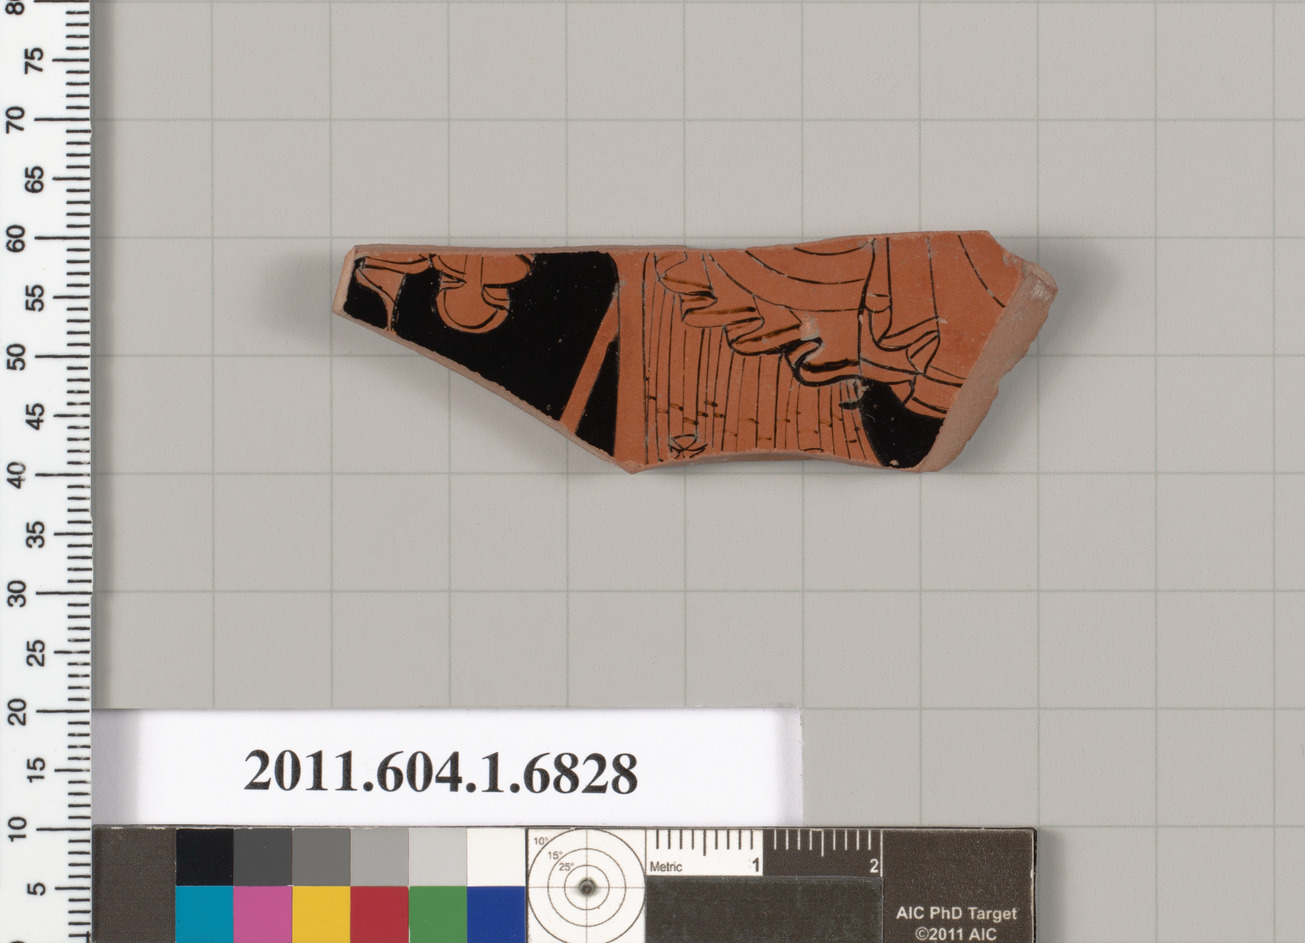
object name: kylix fragment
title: Terracotta fragment of a kylix (drinking cup)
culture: greek, attic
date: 490-470 BCE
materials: terracotta